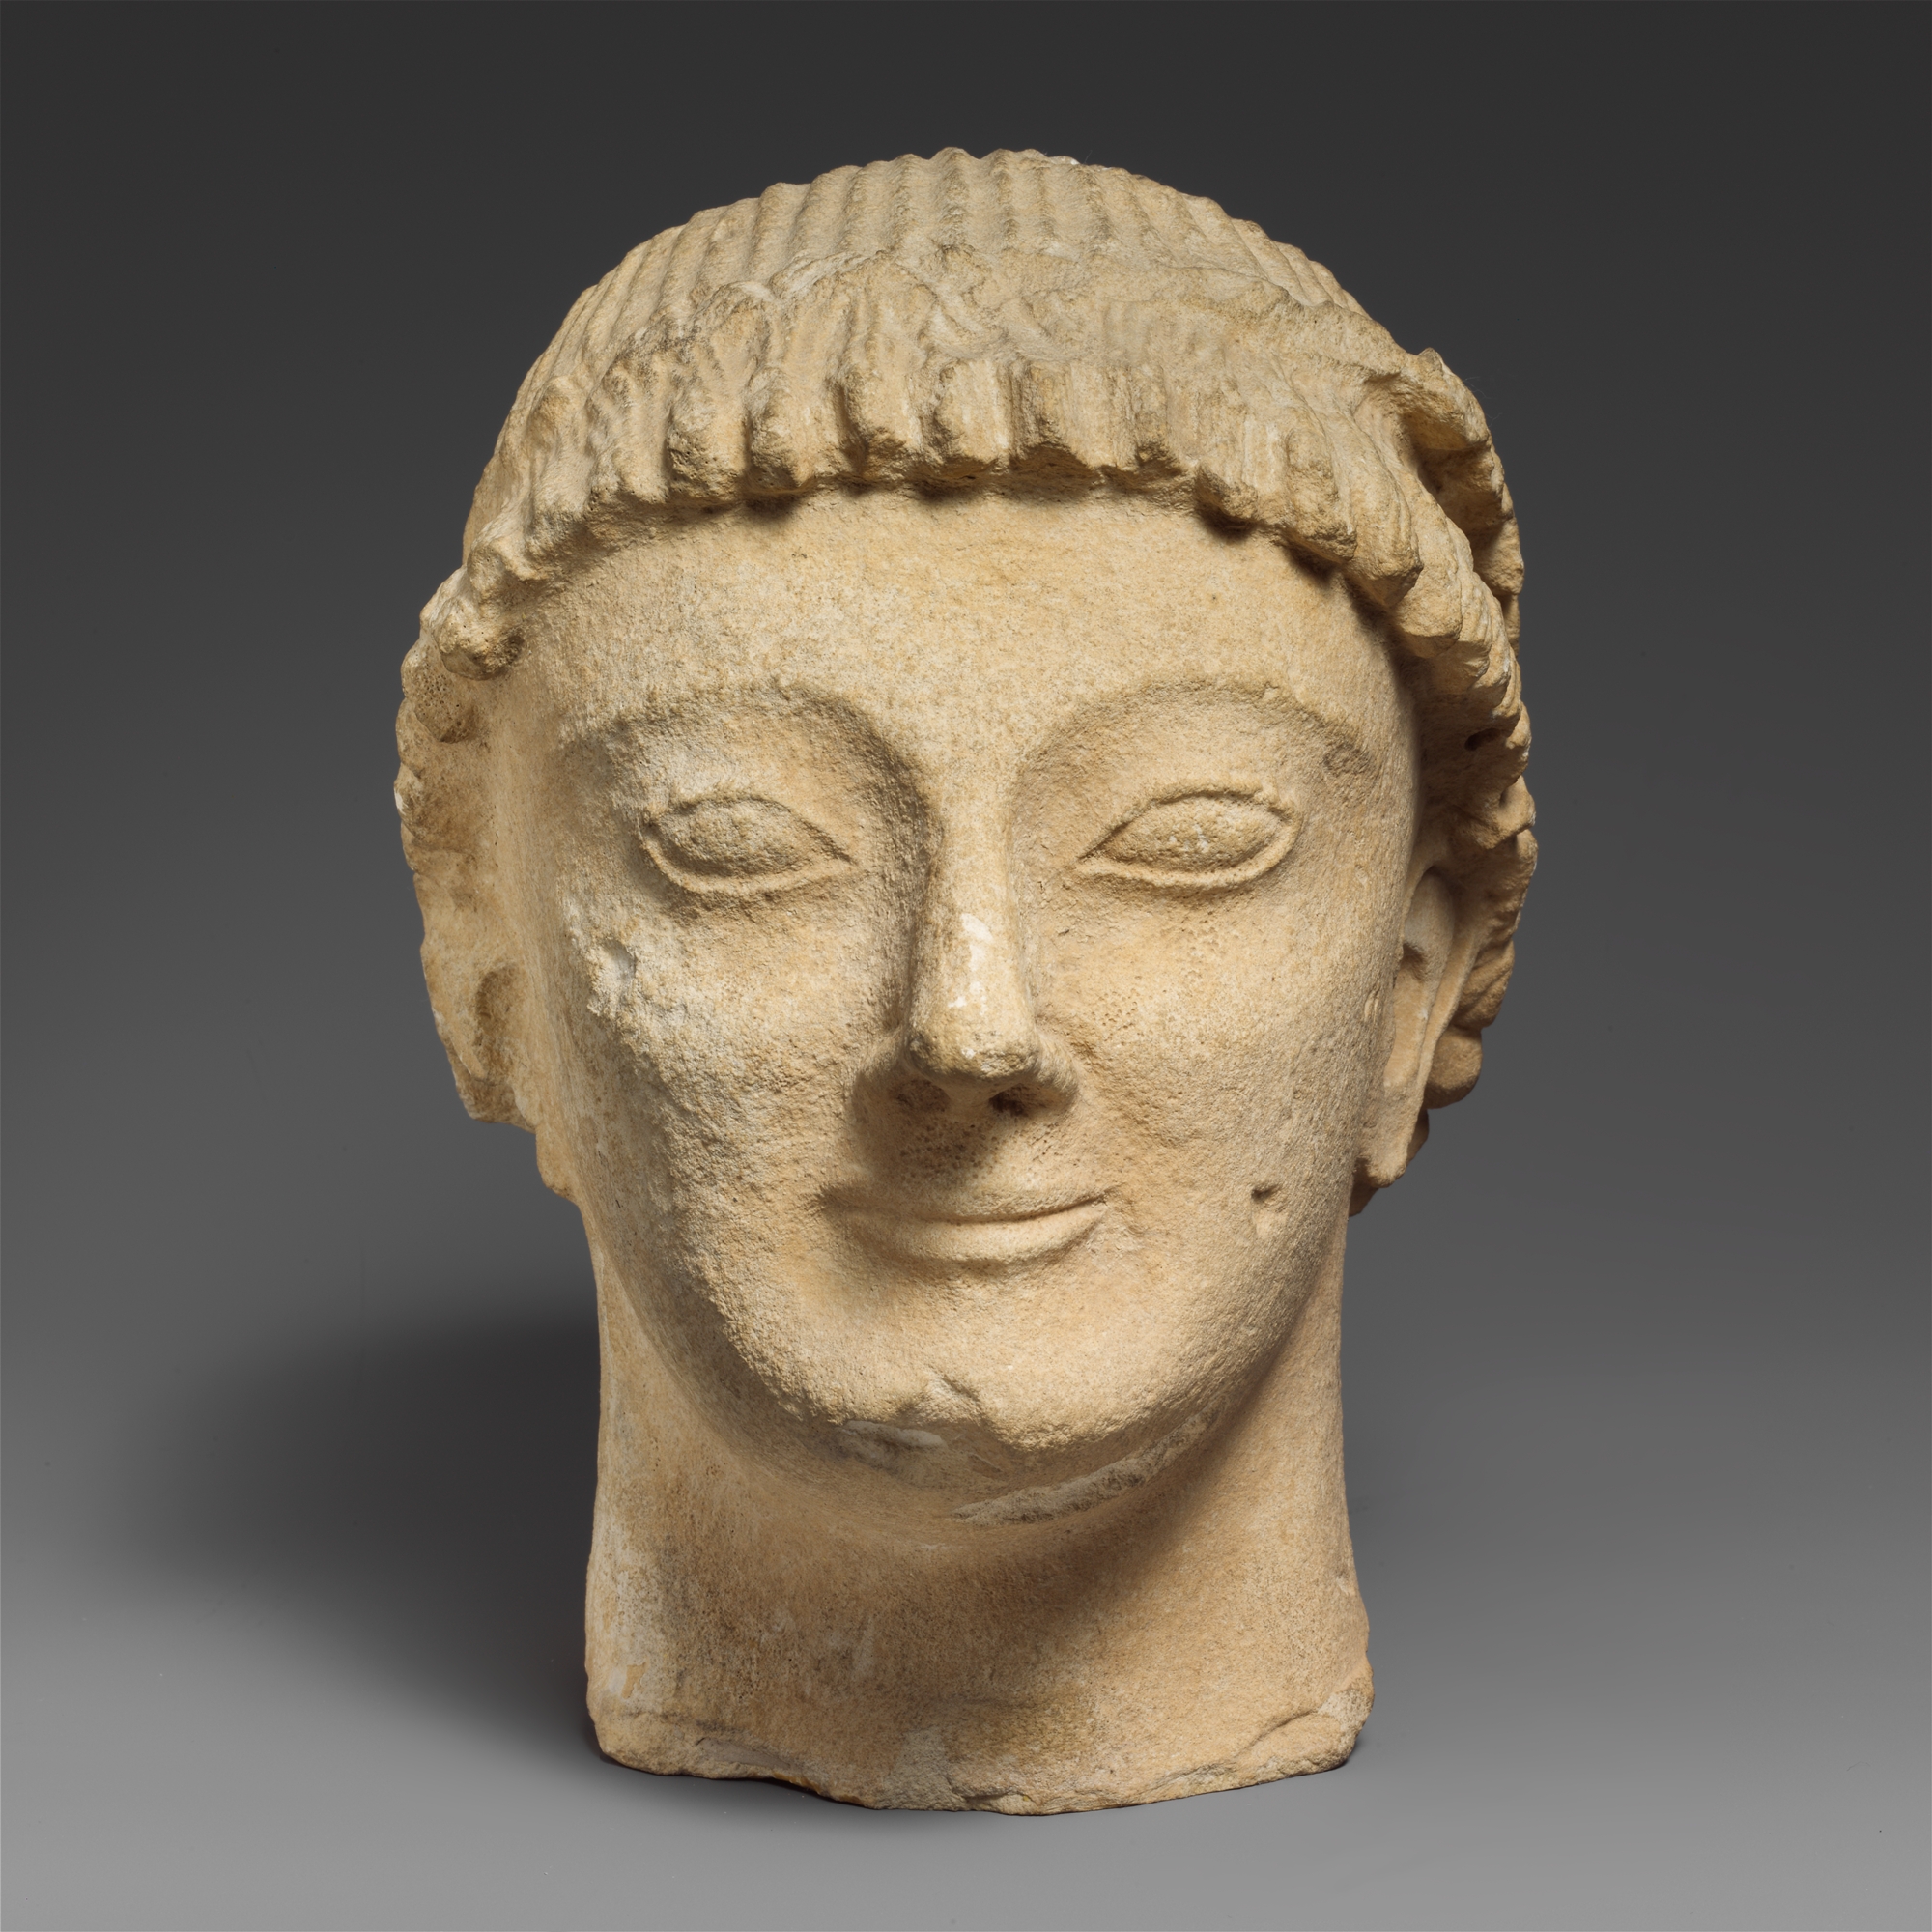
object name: head of a man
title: Limestone head of a beardless male votary with a wreath of rosettes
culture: cypriot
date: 525-501 BCE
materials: limestone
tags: heads,men,wreaths